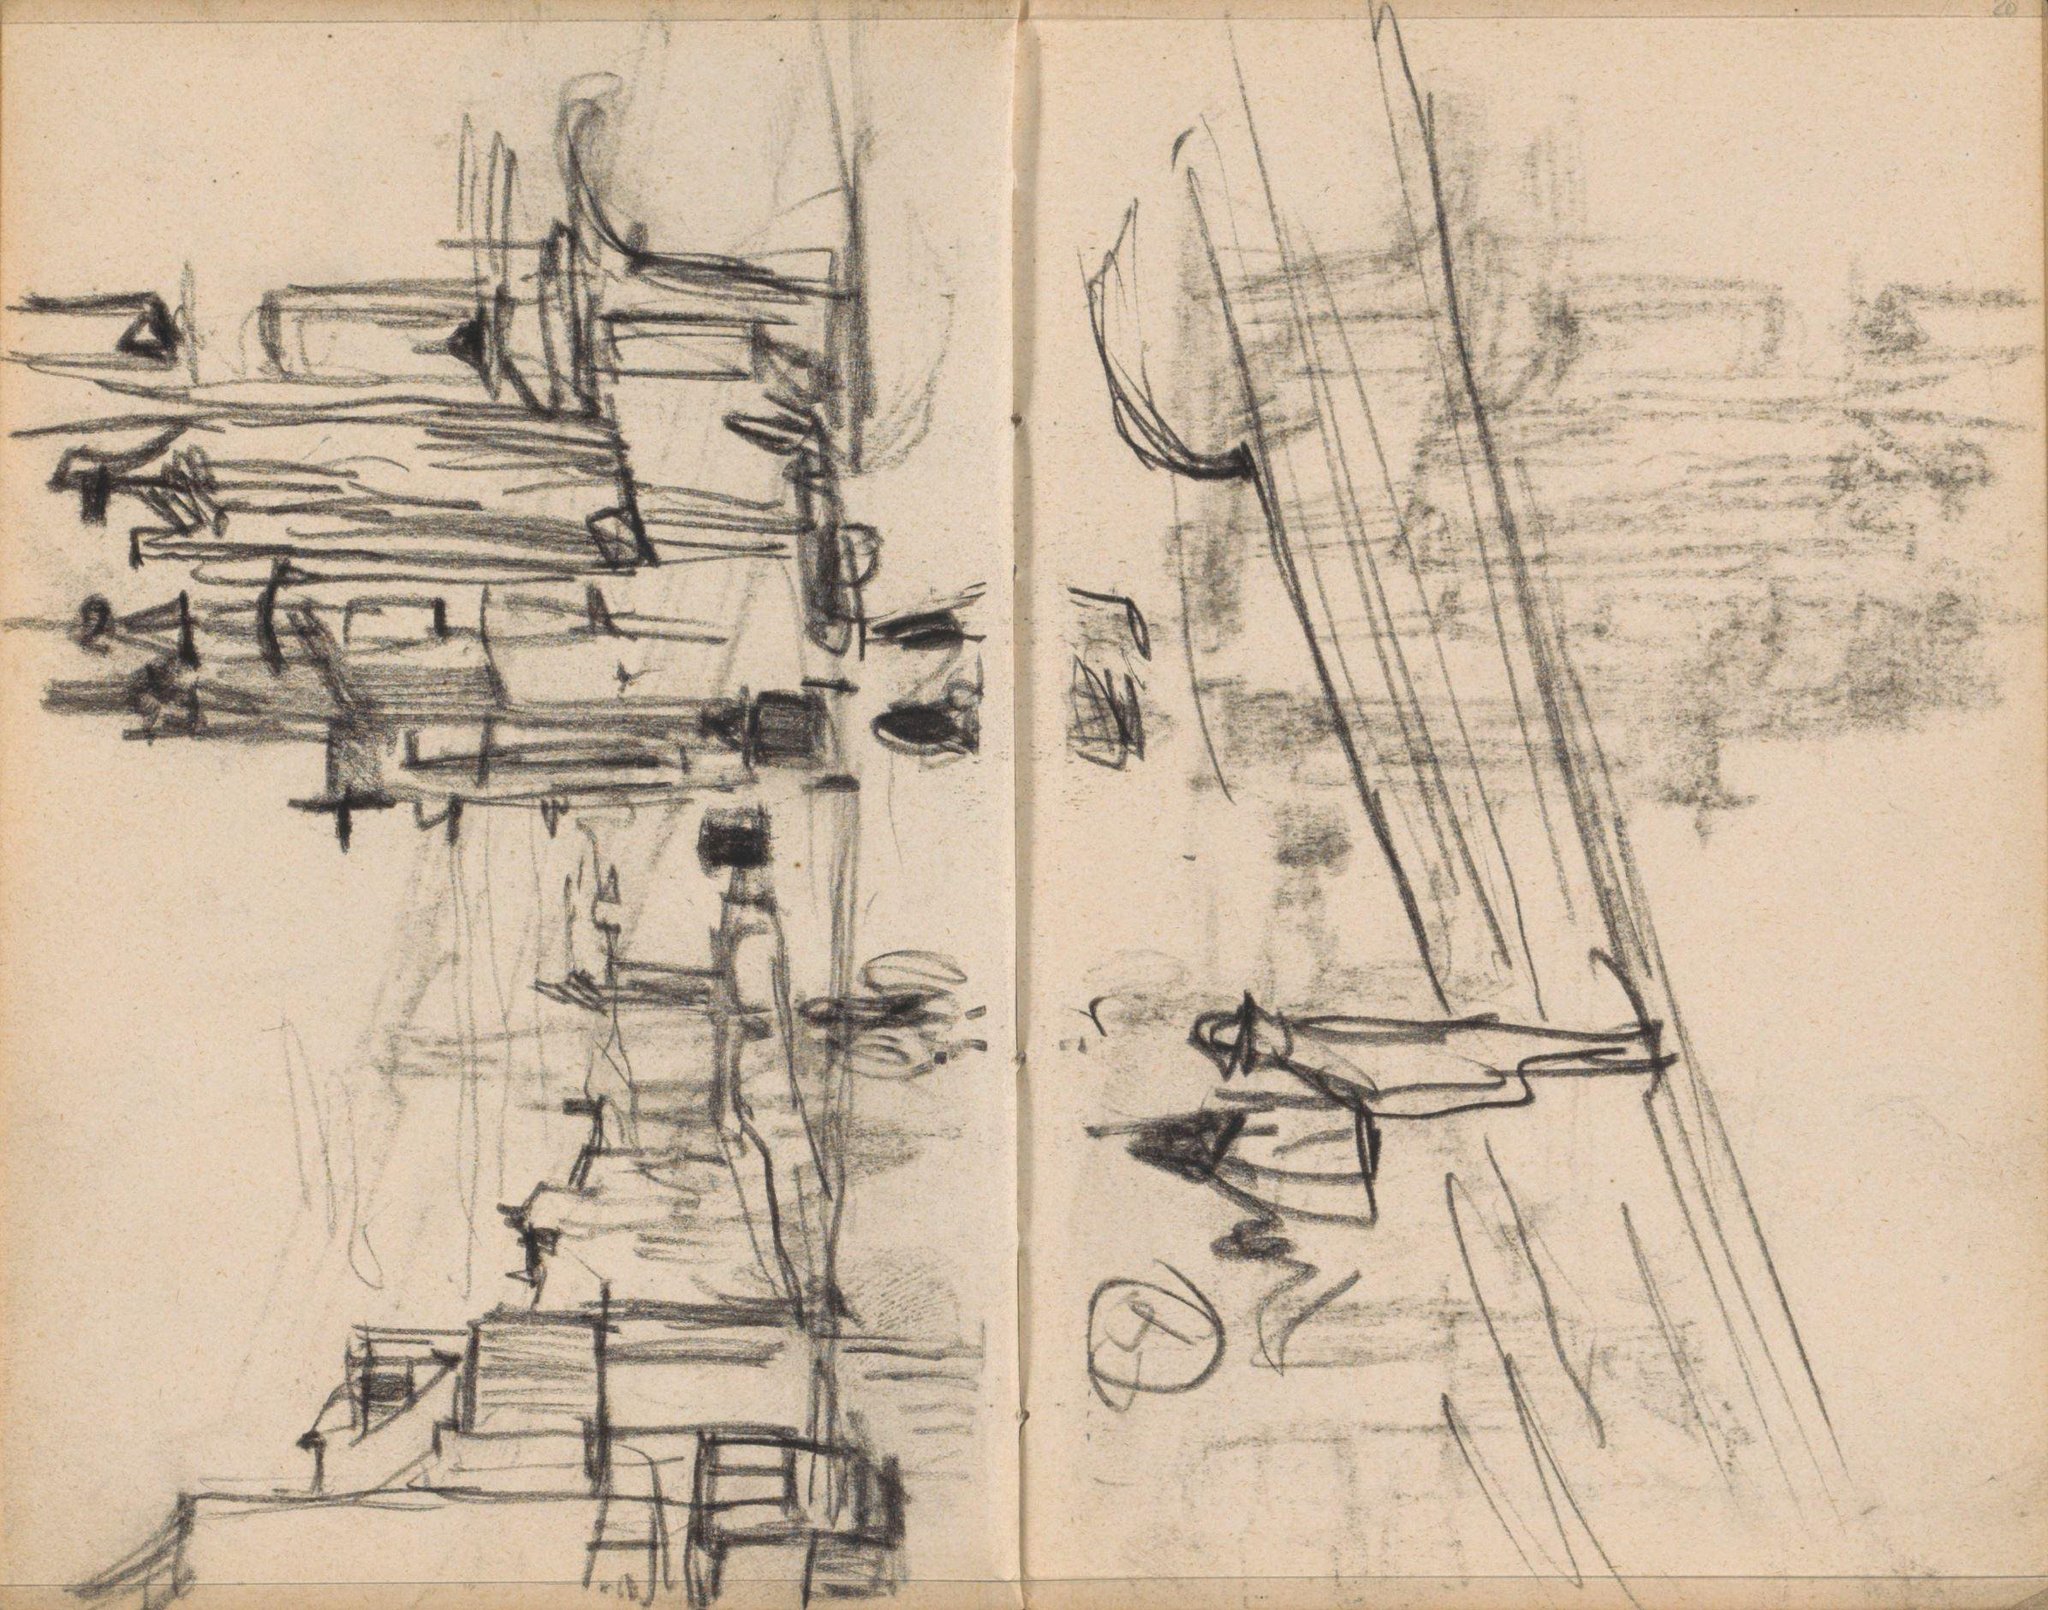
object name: sketchbook leaf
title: Gezicht in Amsterdam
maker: george hendrik breitner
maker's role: draughtsman, painter, print maker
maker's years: 1857-1923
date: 1902-1914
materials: chalk, paper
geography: amsterdam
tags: urban housing, bridge in city across river, canal, etc., amsterdam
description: Gezicht in Amsterdam. In het midden een brug. Vooraan figuren. Pagina 27 en pagina 28 uit een schetsboek met 46 bladen vervaardigd te Noord-Holland en Utrecht.